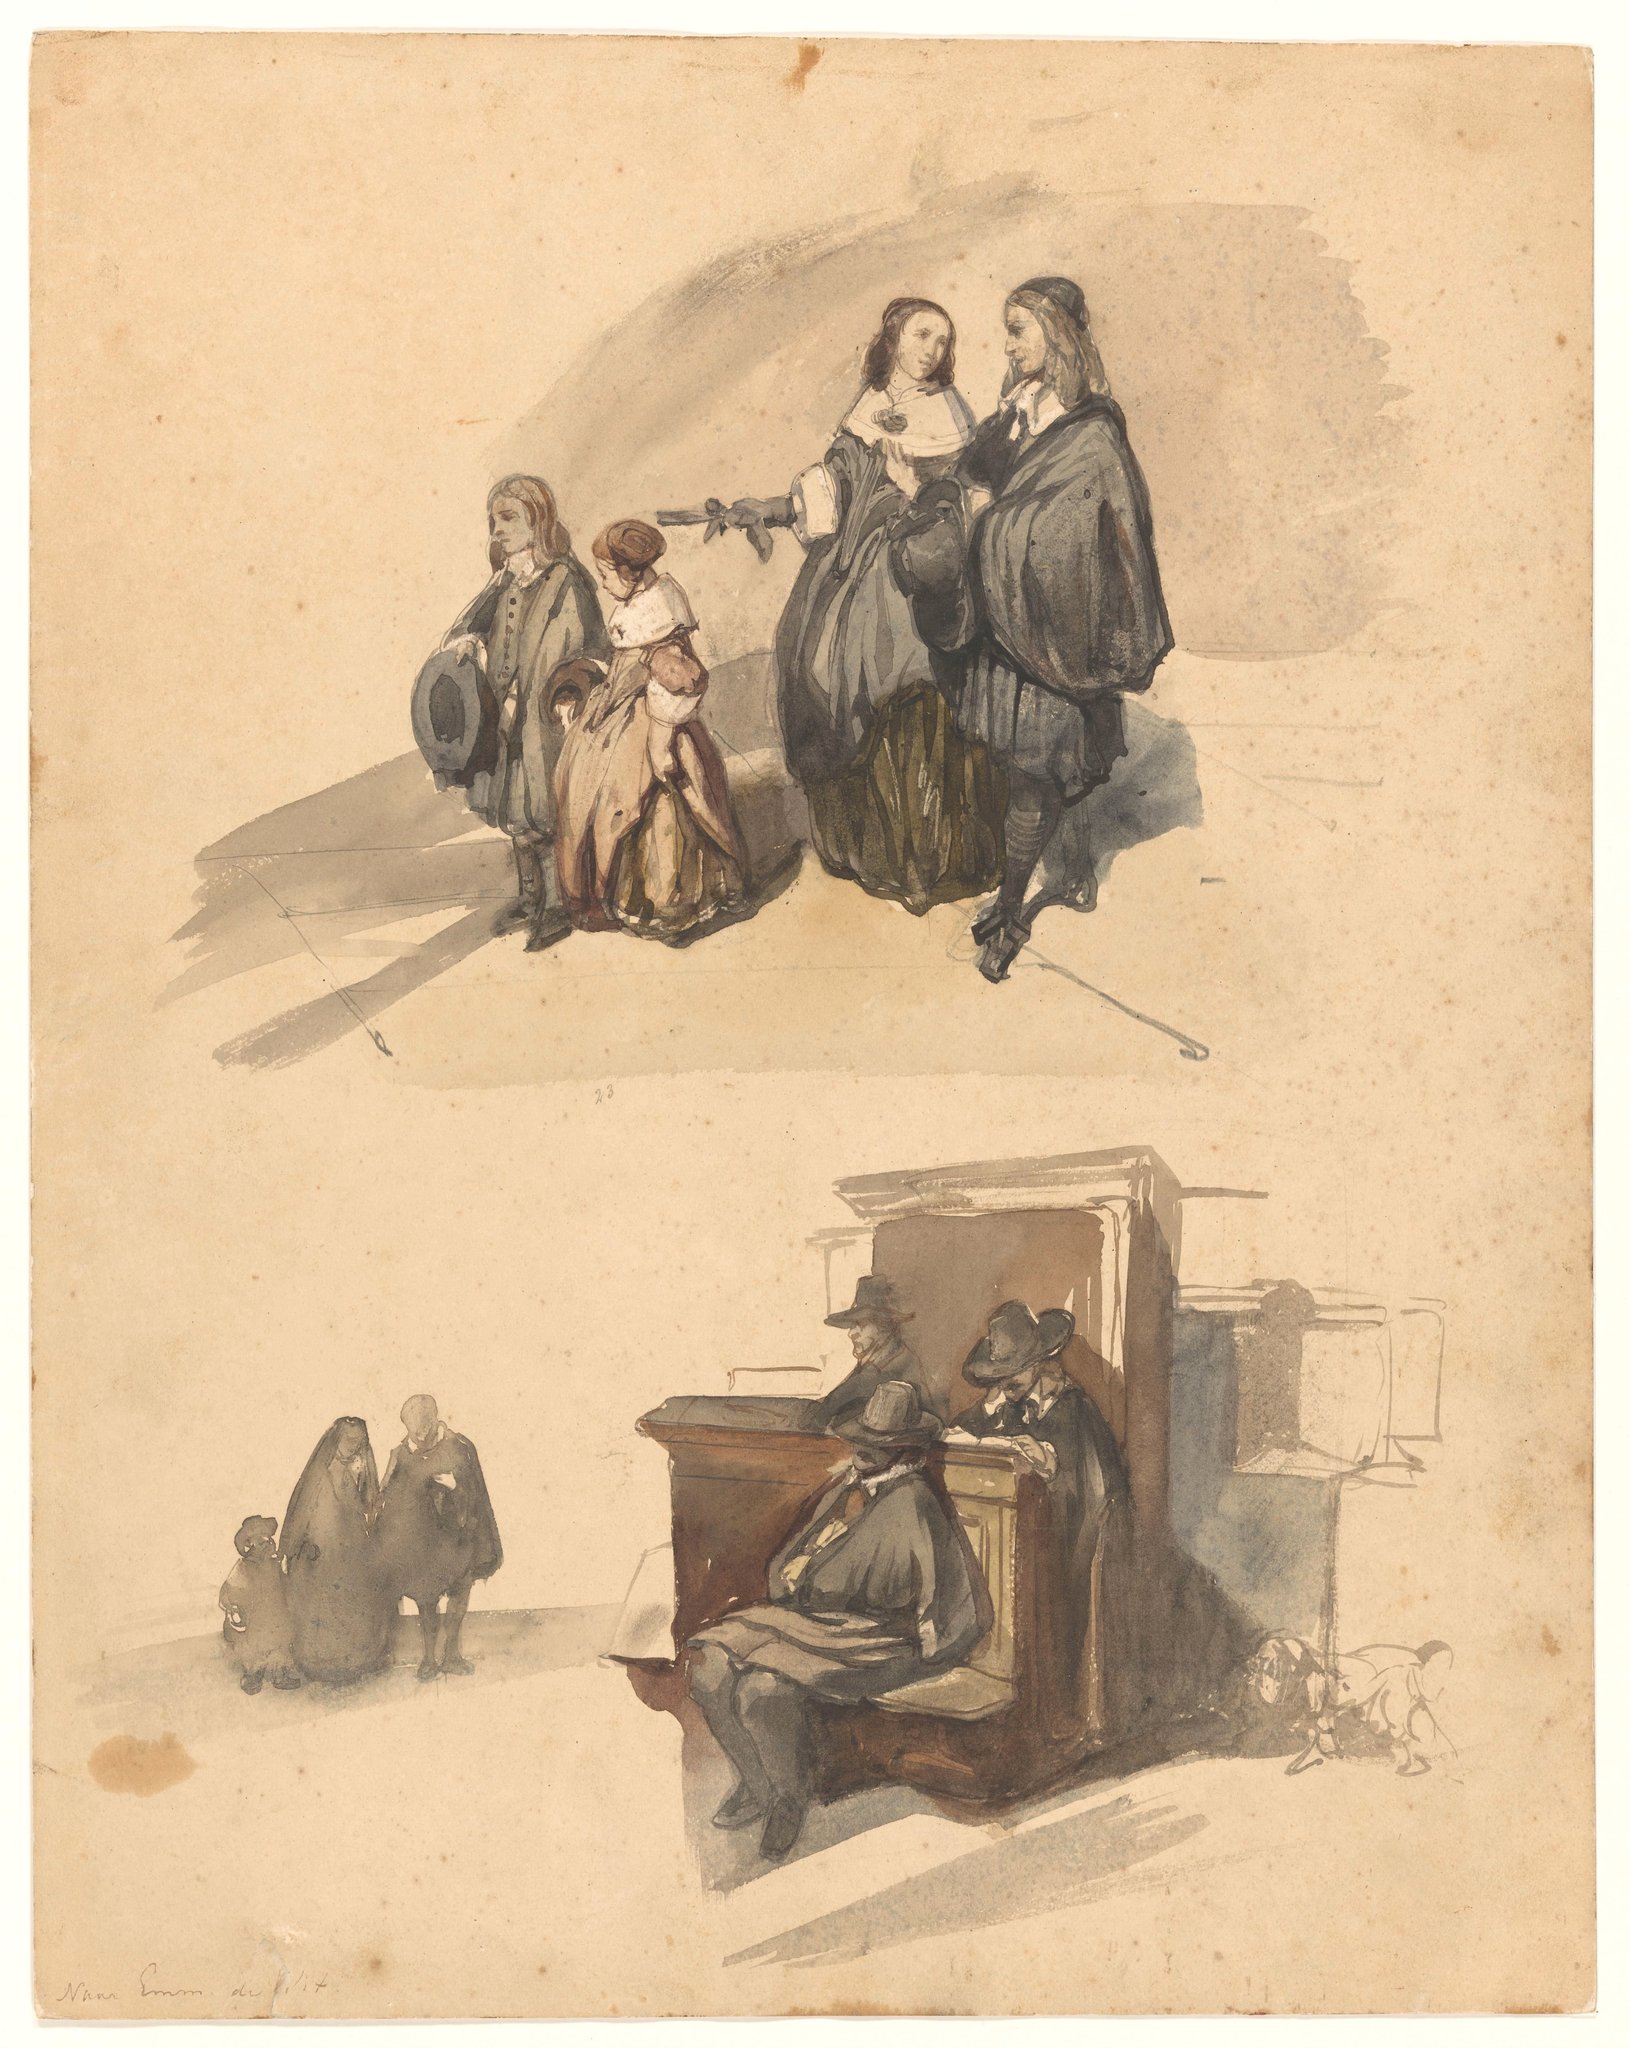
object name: drawing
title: Studies naar figuren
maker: johannes bosboom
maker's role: draughtsman, painter, print maker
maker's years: 1817-1891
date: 1827-1891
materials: ink, paper, pencil, watercolor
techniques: brush, pen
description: Studies naar figuren in een schilderij van Emmanuel de Witte.